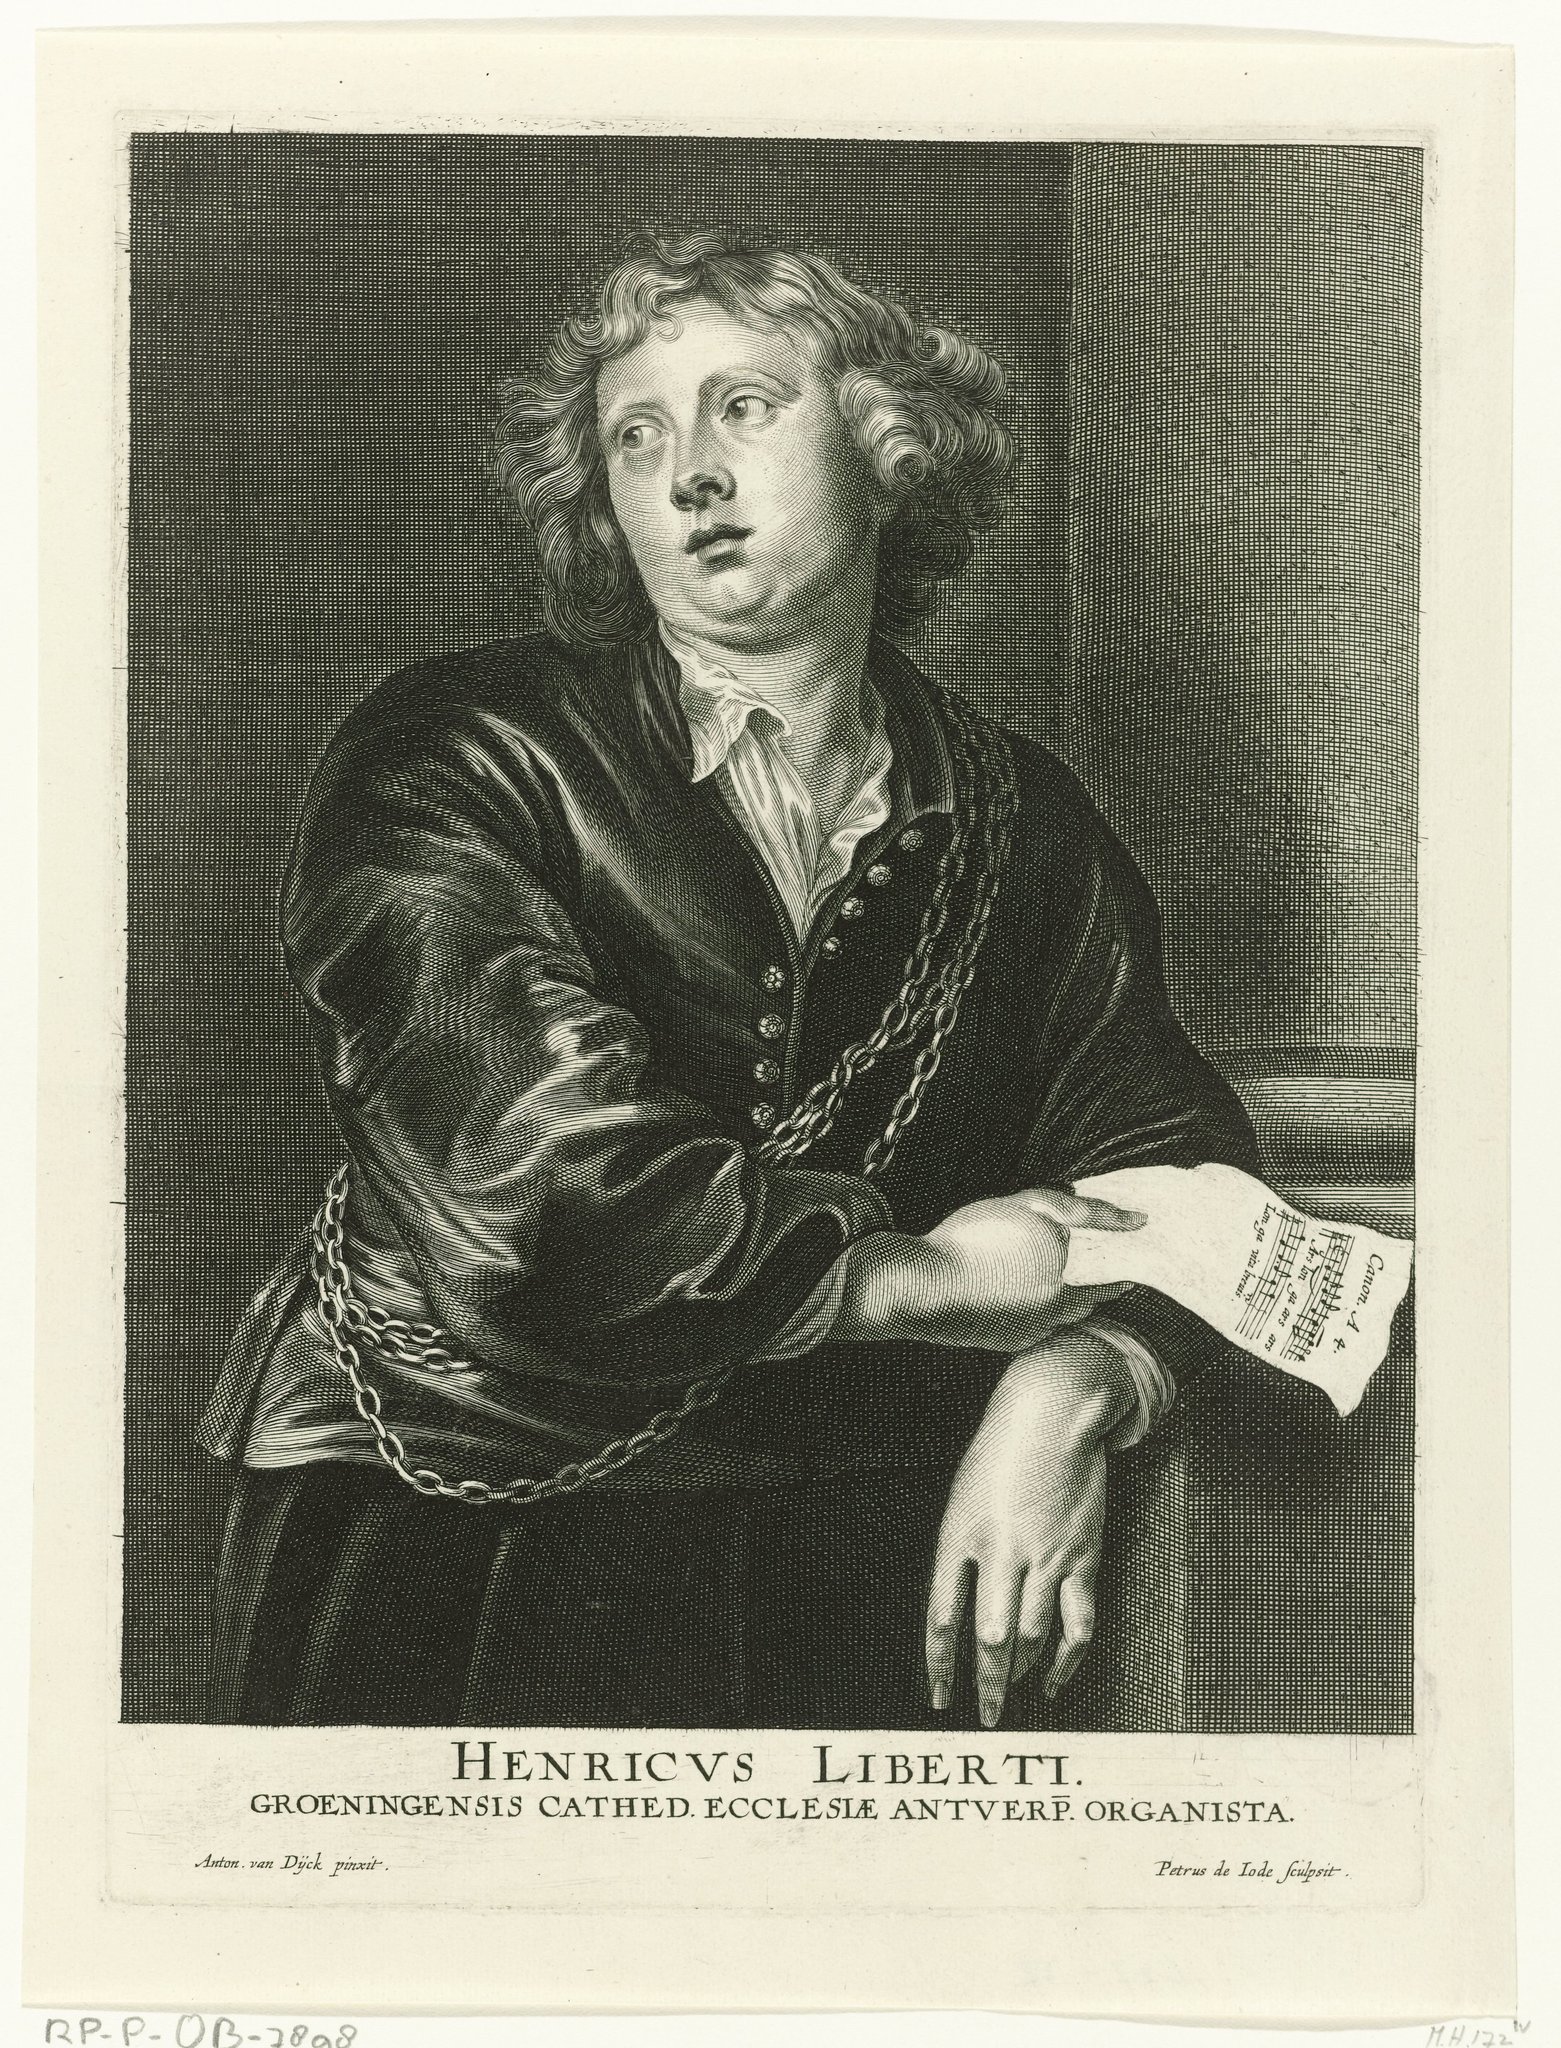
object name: print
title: Portret van Henricus Liberti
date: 1628-1670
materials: paper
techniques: engraving, etching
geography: antwerp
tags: antwerp, notation of music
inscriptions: collector's mark: Lugt 240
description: Portret van de organist Henricus Liberti, ten halven lijve. In zijn rechterhand houdt hij bladmuziek. In de marge de naam van de geportretteerde en een onderschrift in het Latijn.